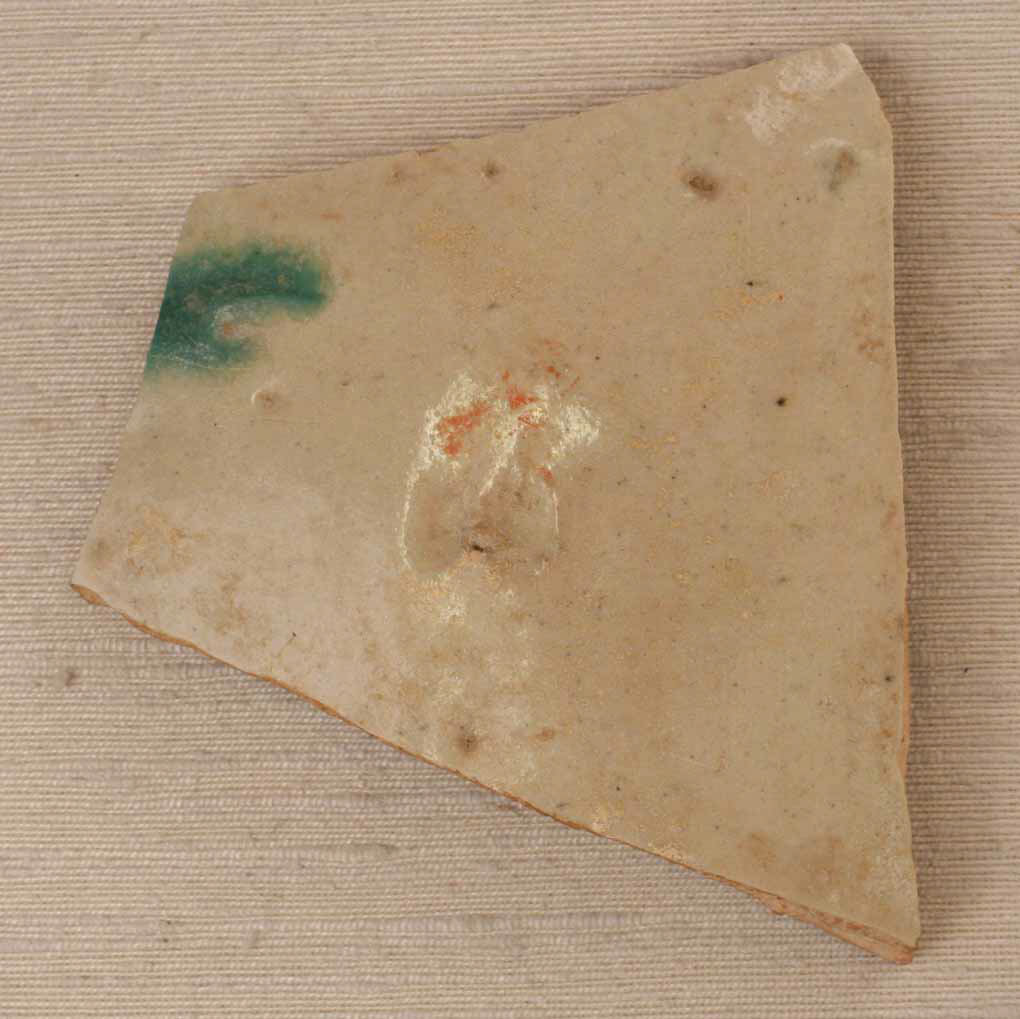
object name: fragment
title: Fragments of Splashed Ceramic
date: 801-900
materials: earthenware, glaze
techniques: painting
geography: iraq